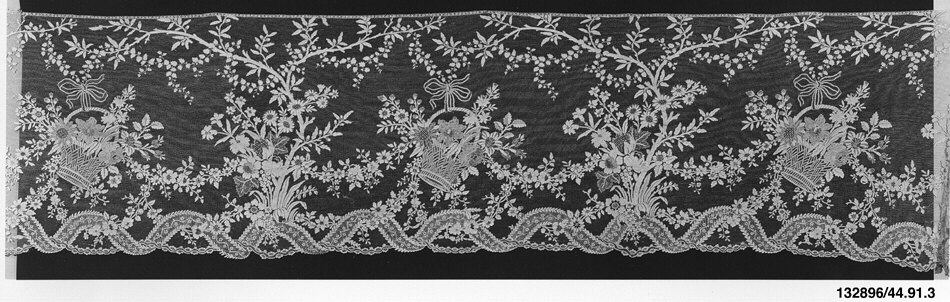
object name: flounce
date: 1734-1766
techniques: lace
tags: flowers